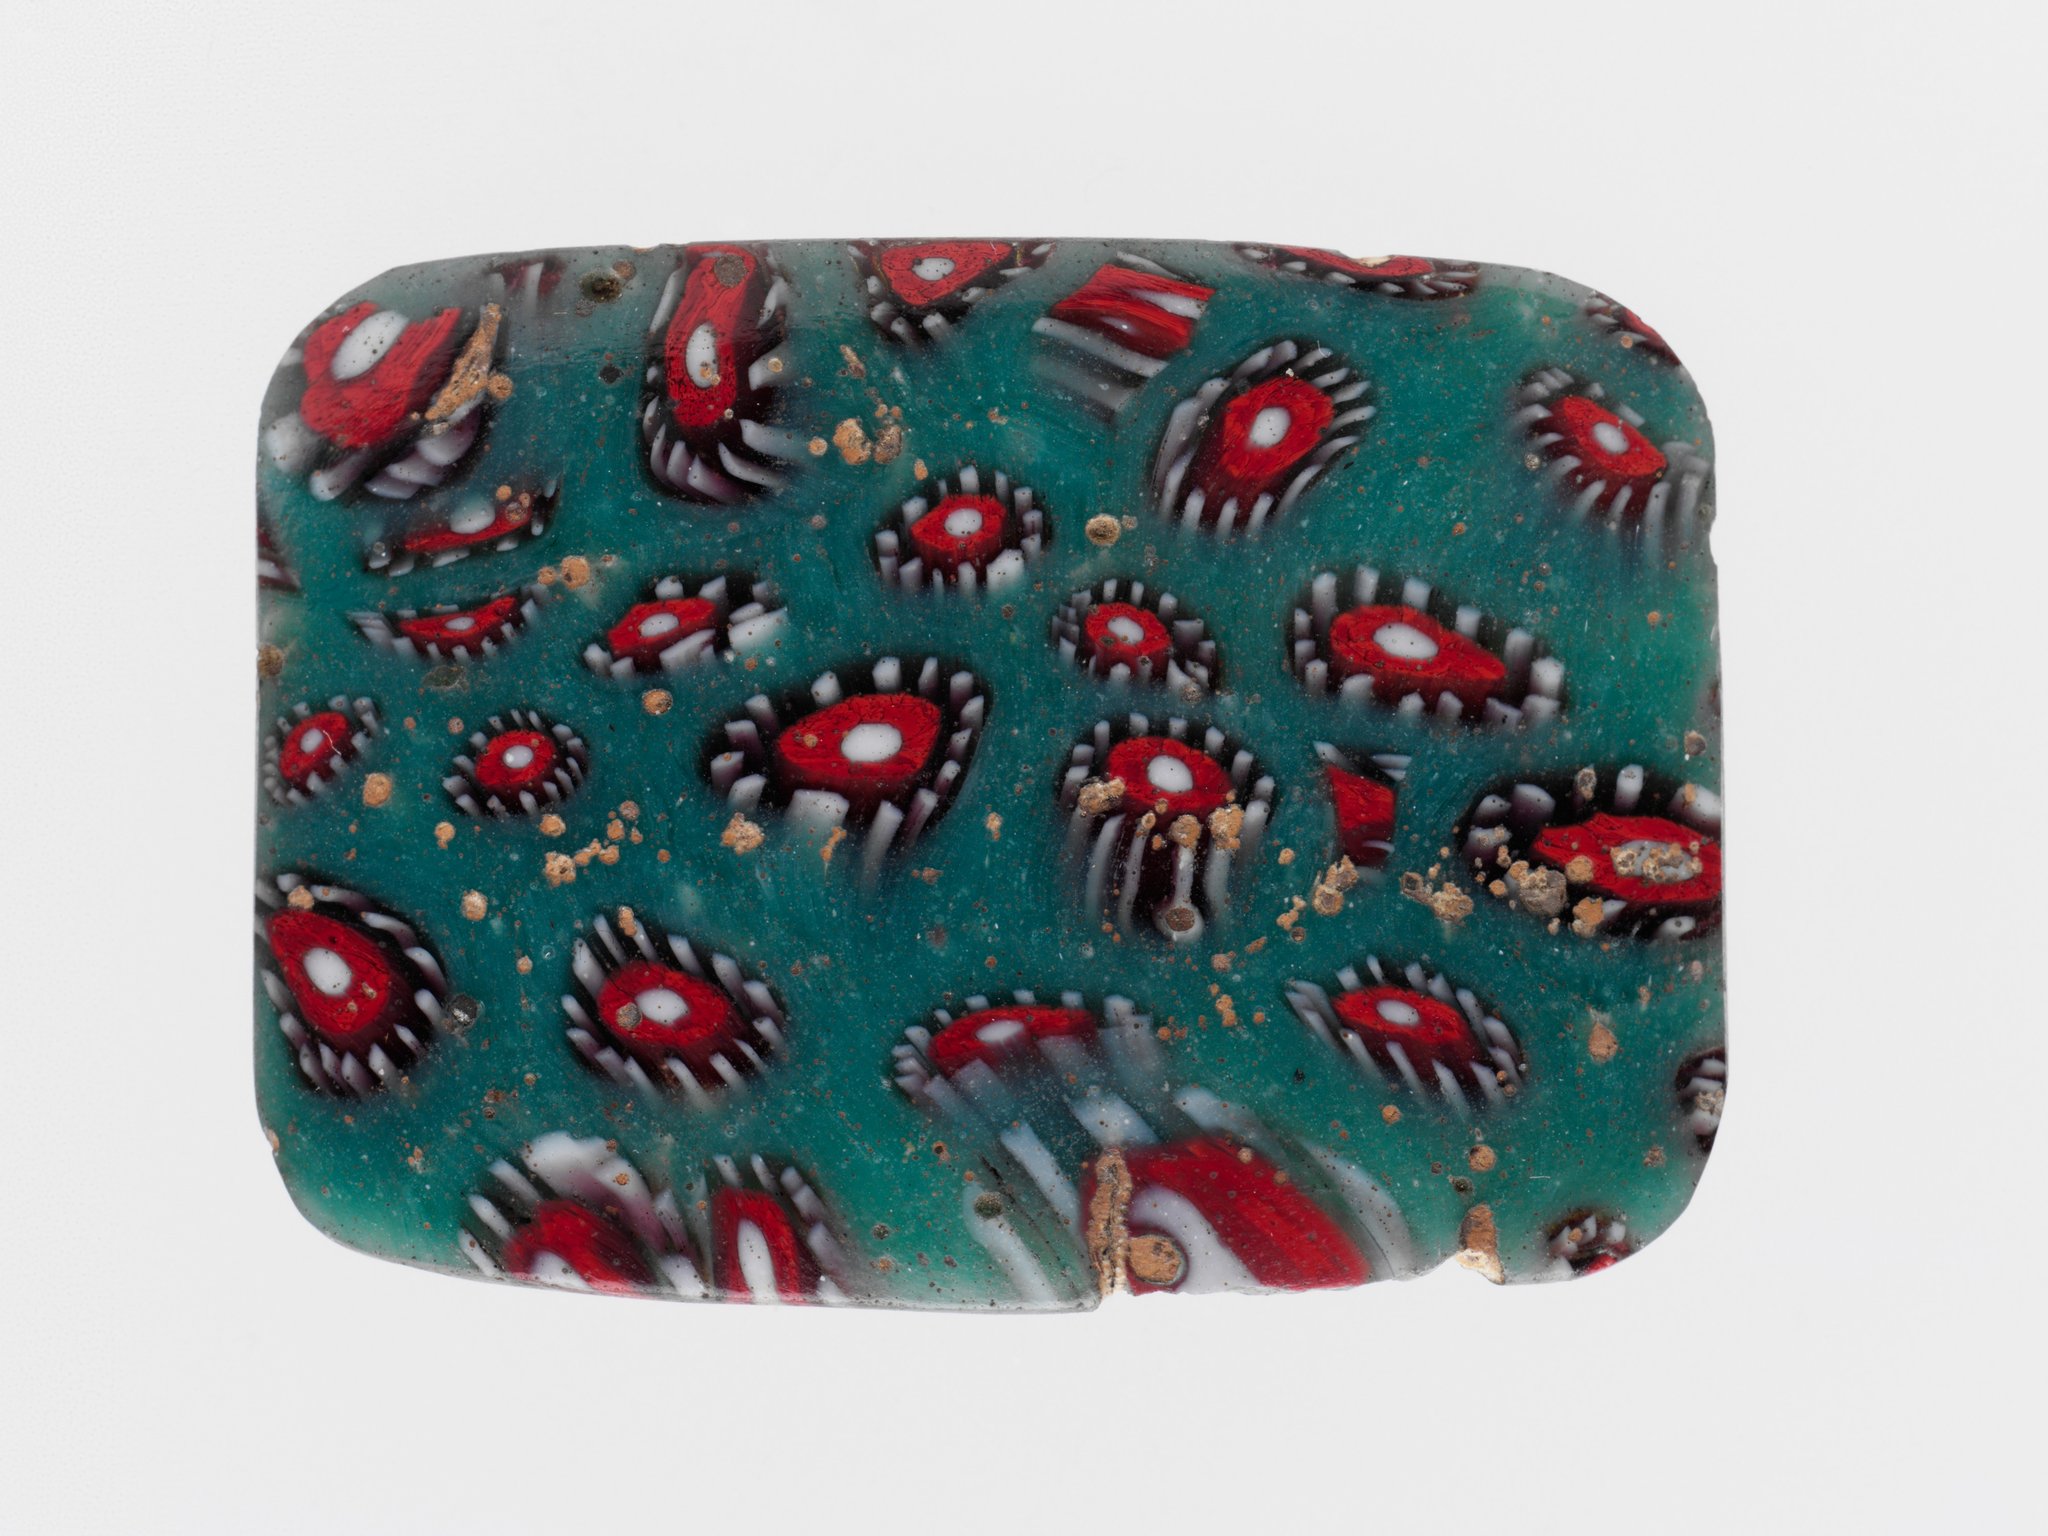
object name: mosaic glass fragment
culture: roman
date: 34 BCE-33 CE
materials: glass